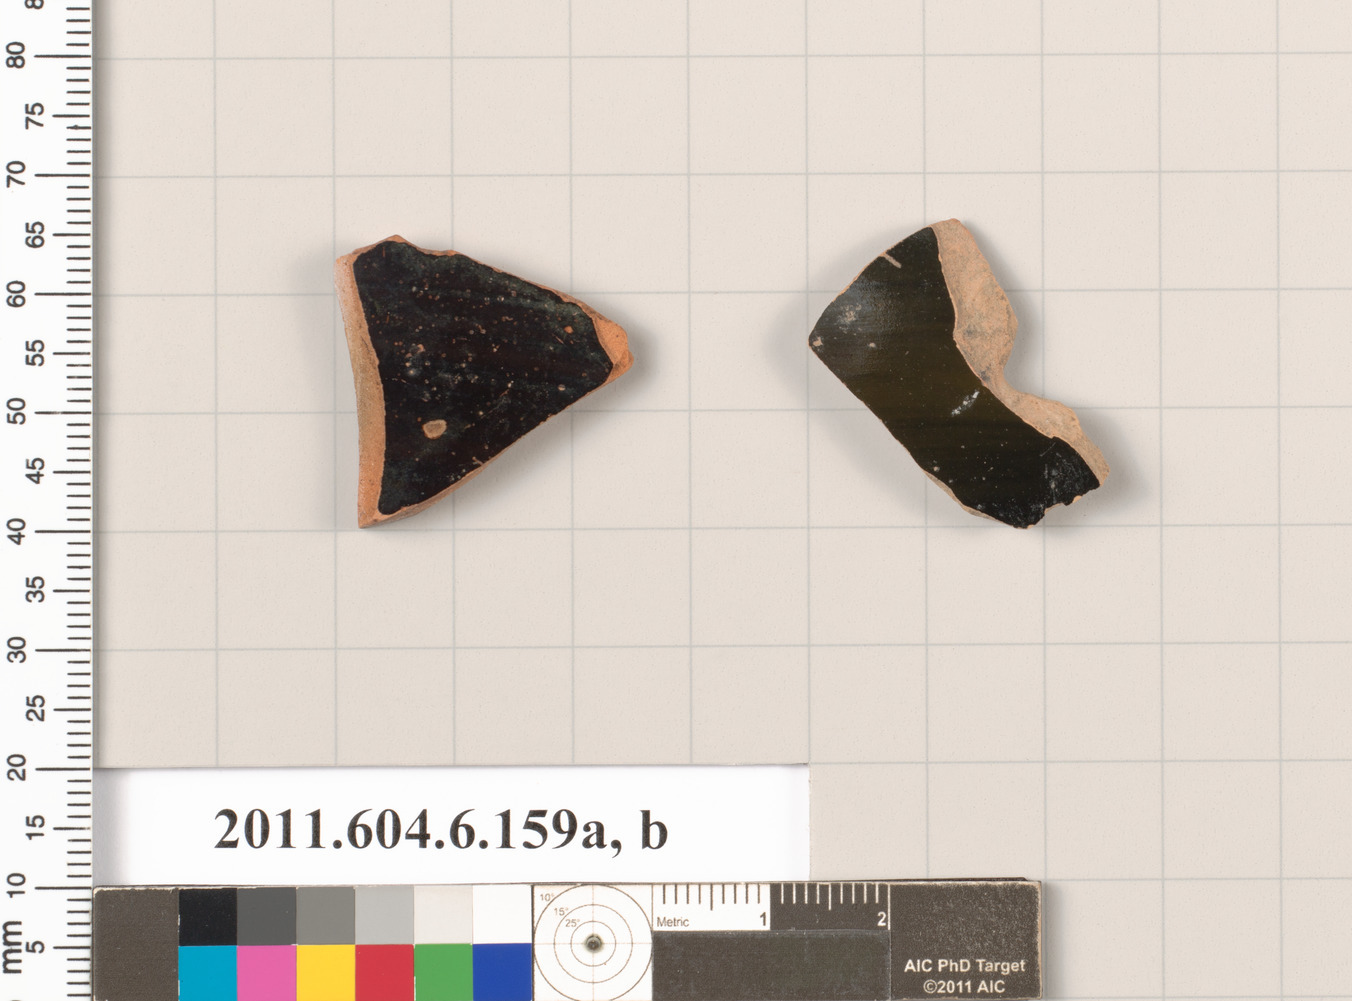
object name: undetermined open shape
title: Terracotta fragments of open shapes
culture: greek, attic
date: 600-401 BCE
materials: terracotta